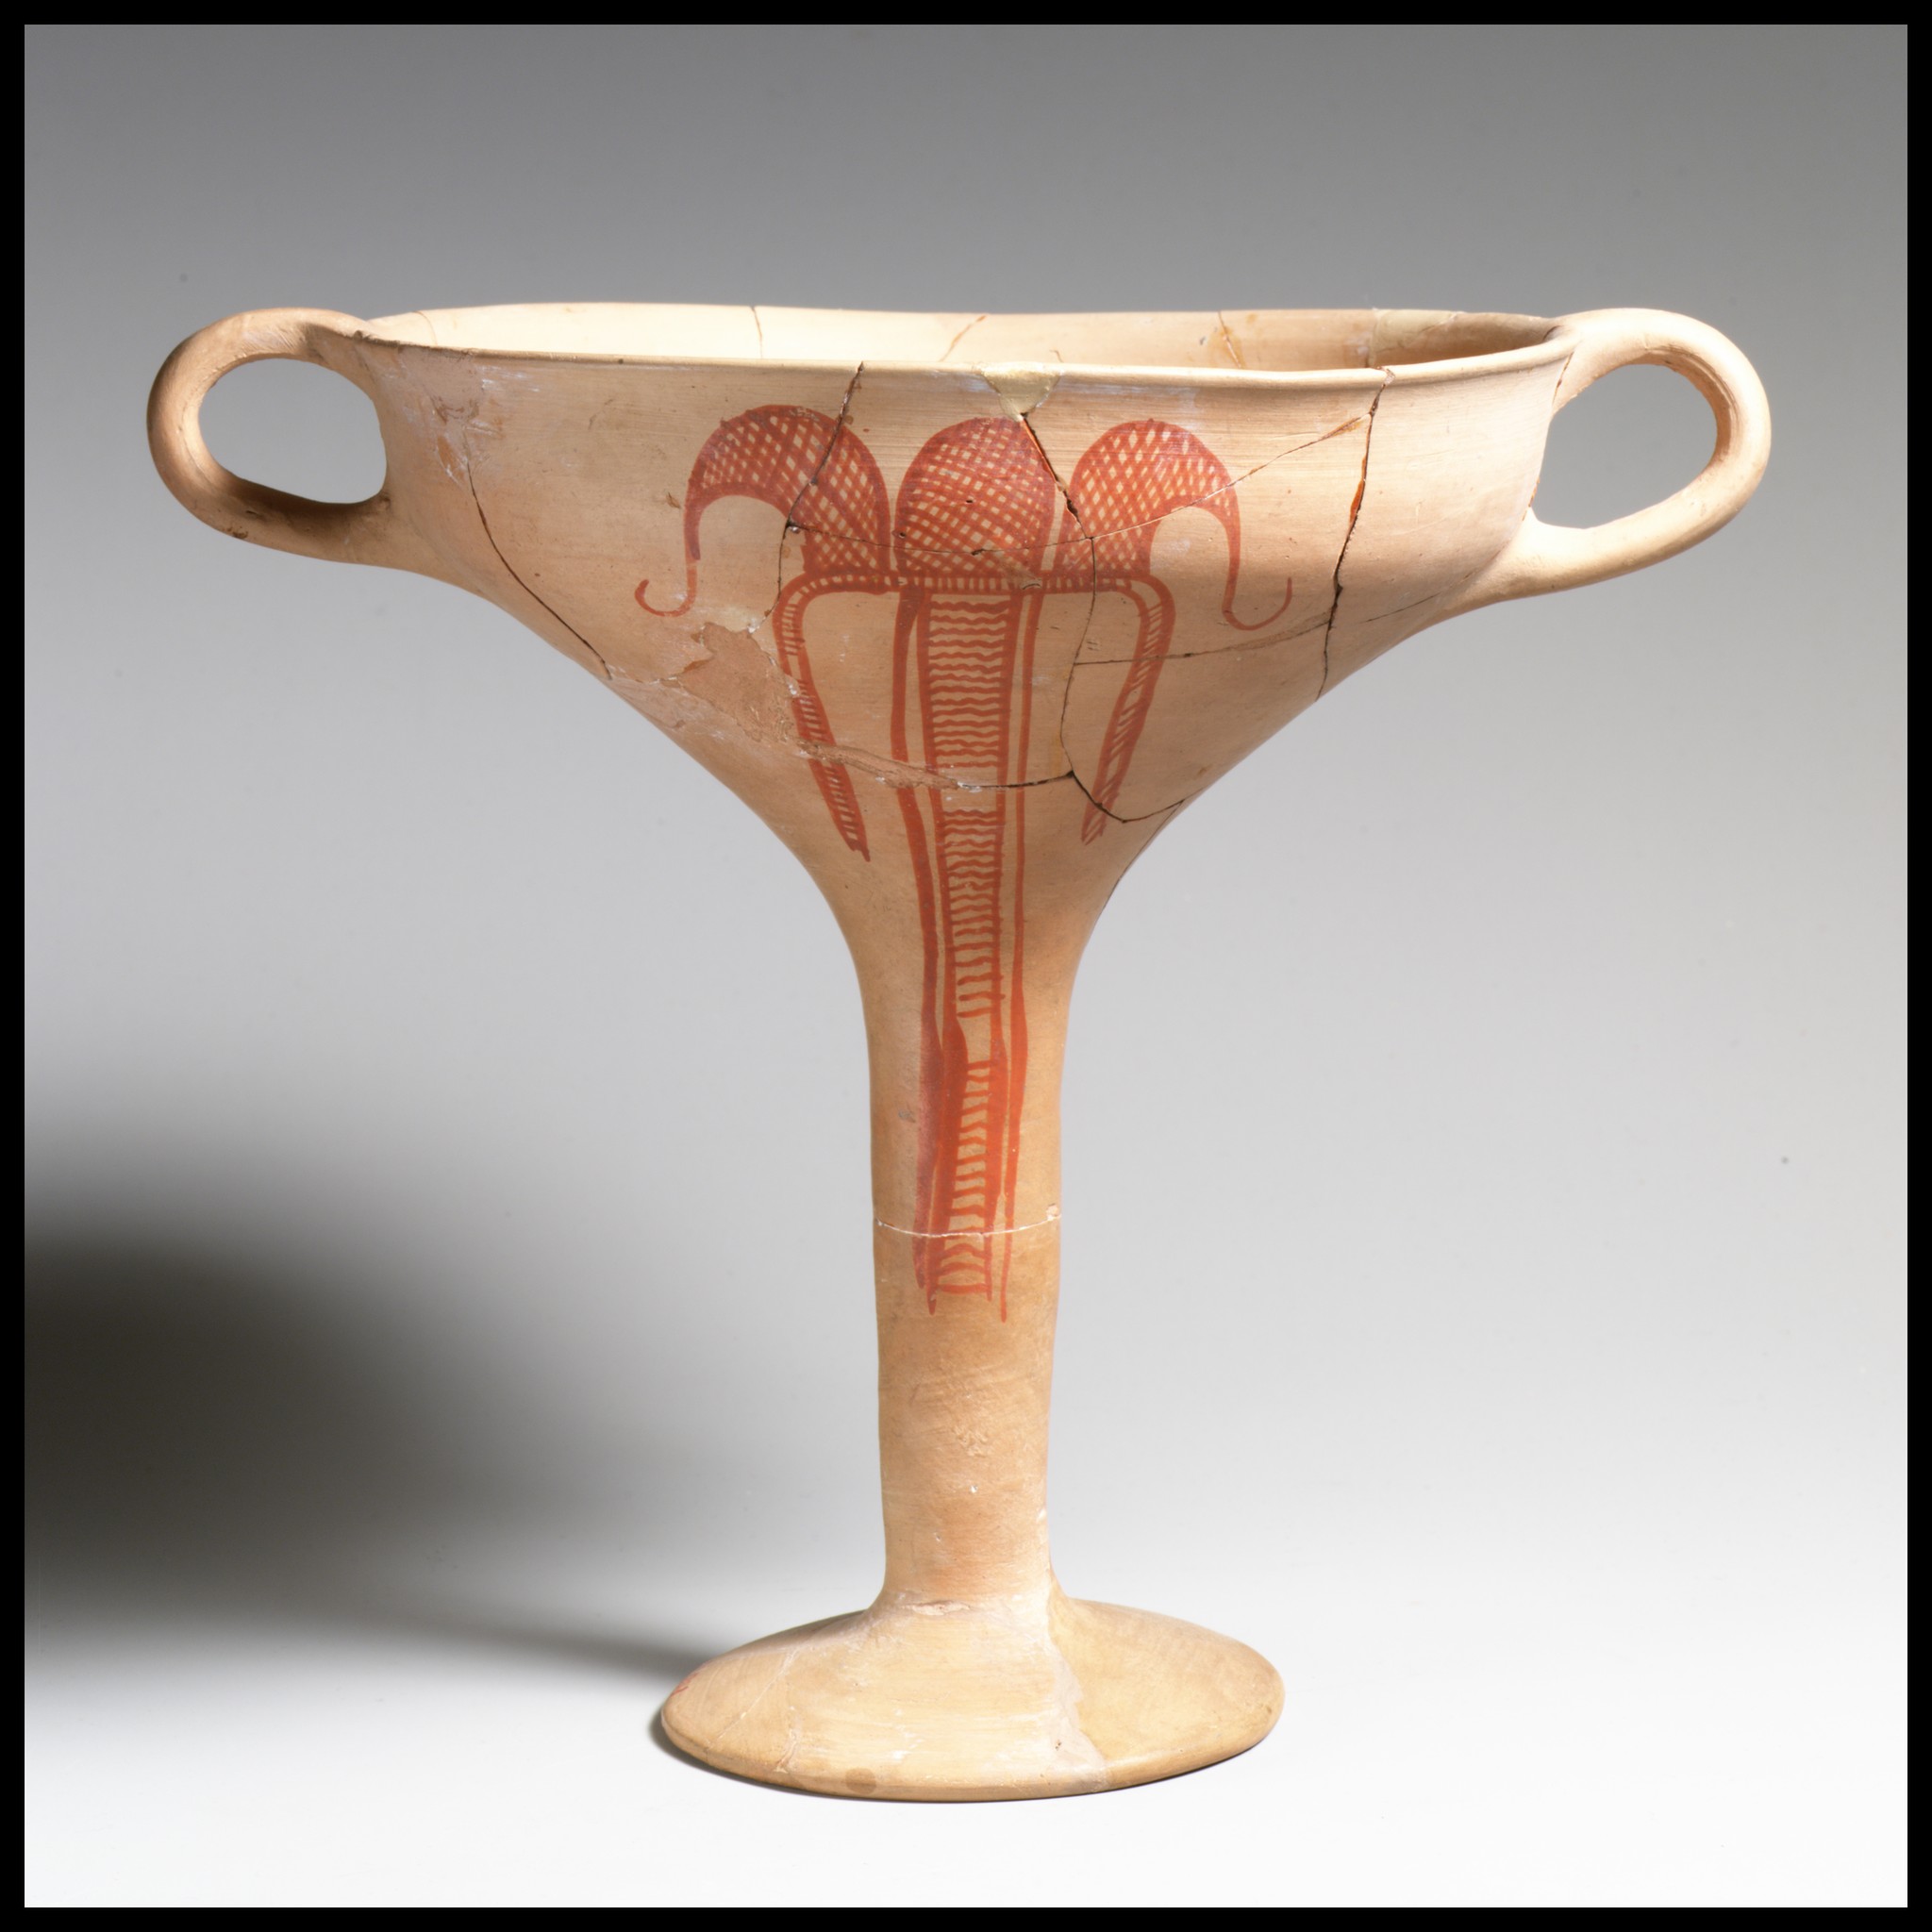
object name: kylix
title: Terracotta kylix (drinking cup) with flower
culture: mycenaean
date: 1300-1225 BCE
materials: terracotta